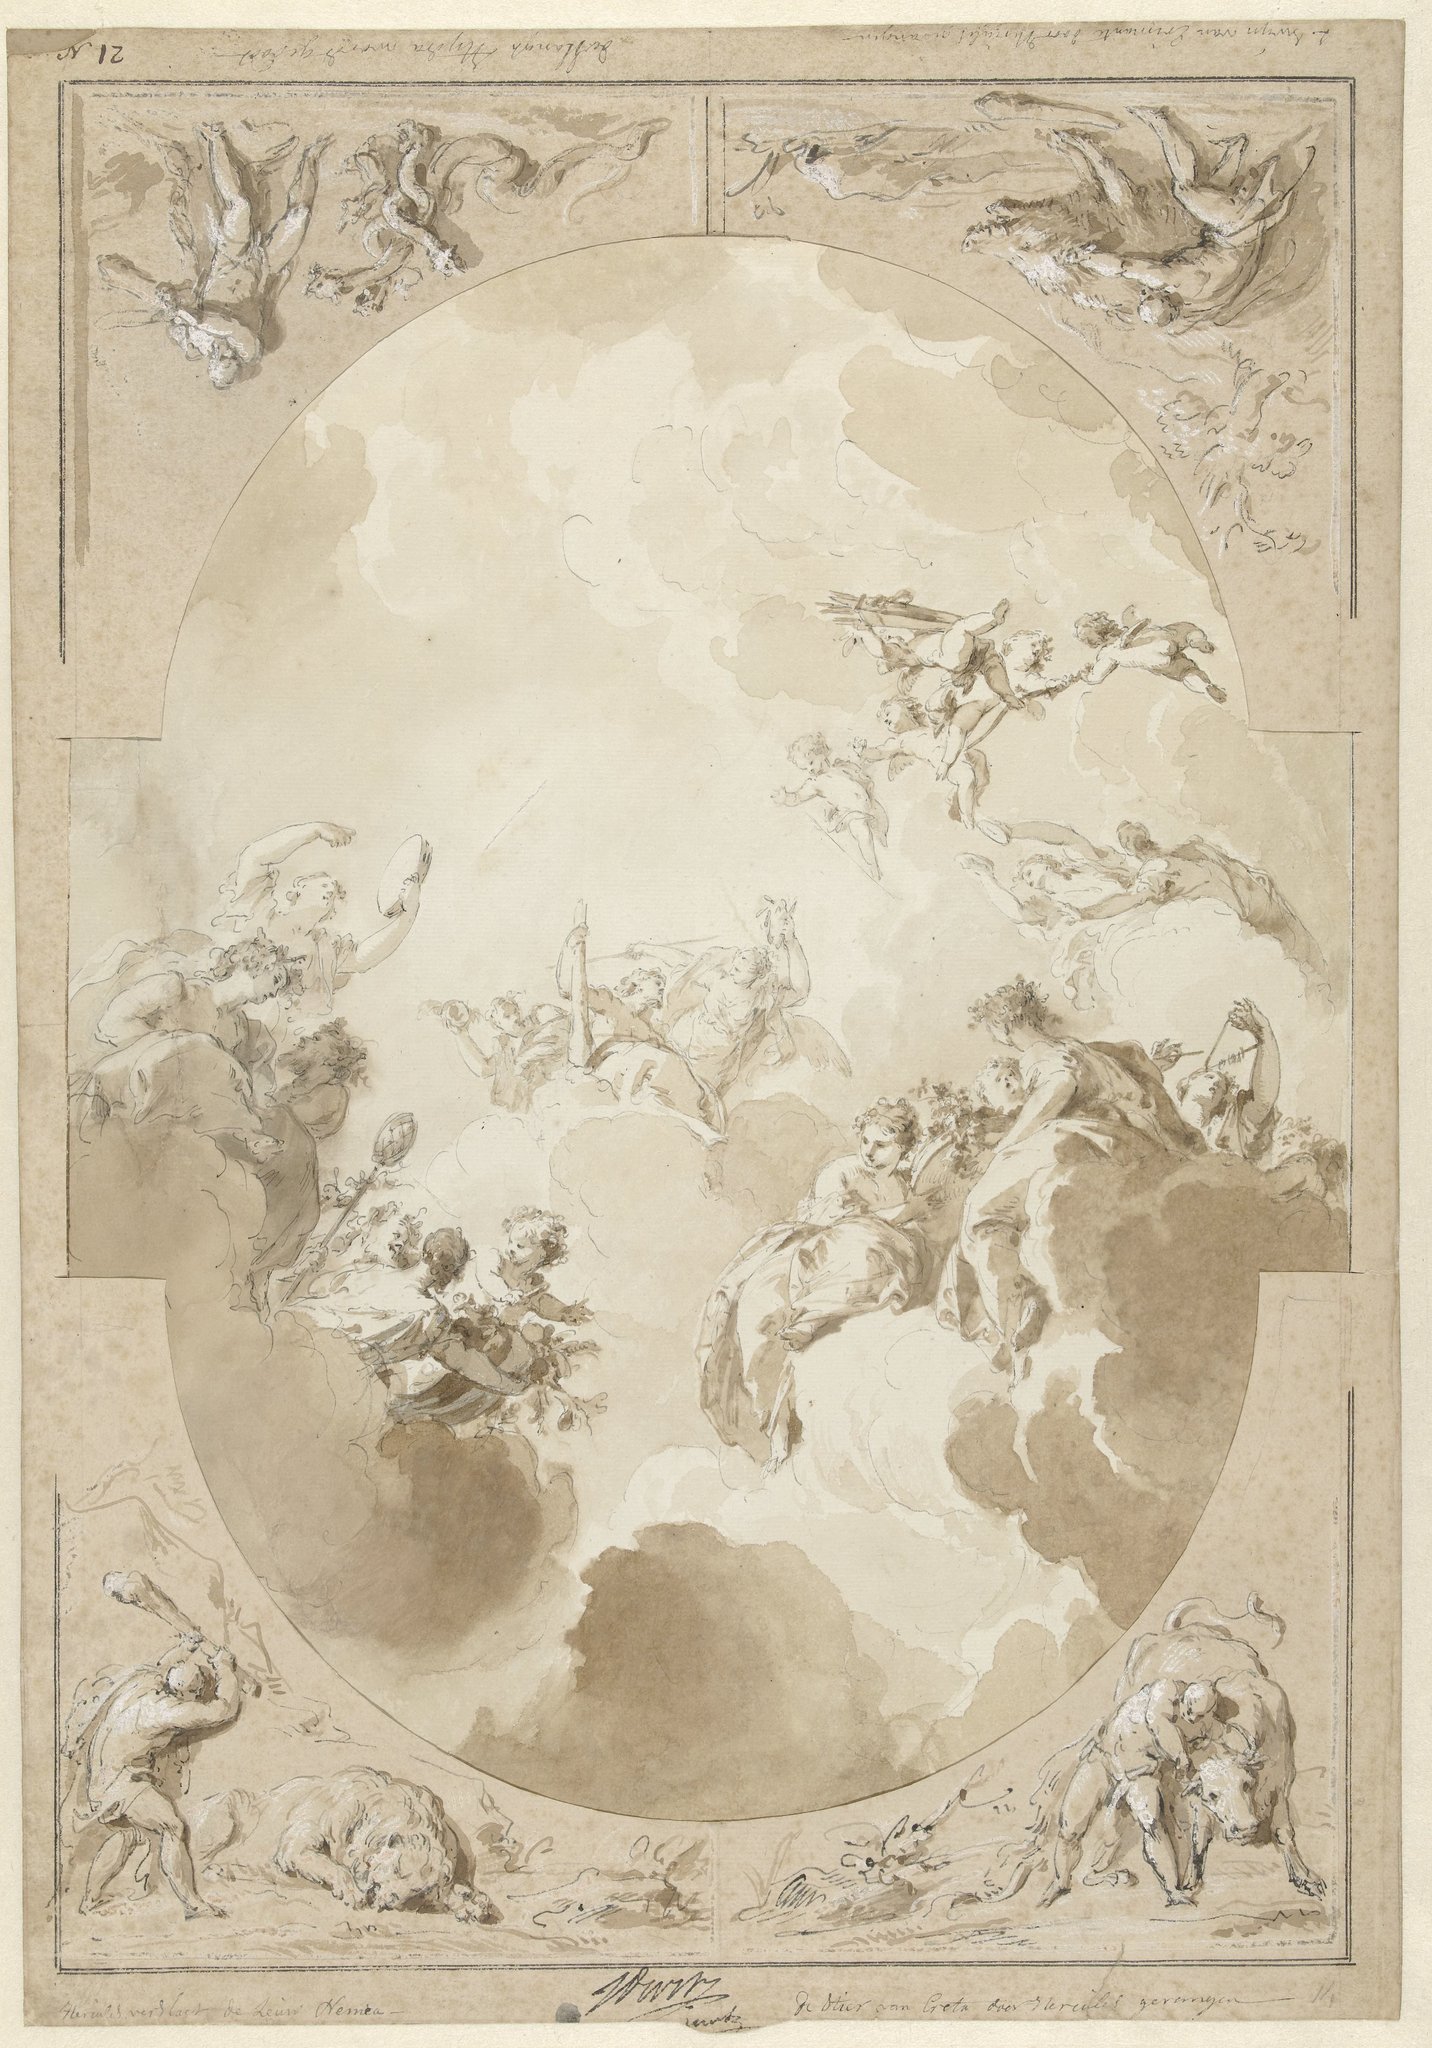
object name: drawing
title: Ontwerp voor een plafondschildering met de apotheose van Hercules en vier van zijn werken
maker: jacob de wit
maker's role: draughtsman, painter, print maker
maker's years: 1695-1754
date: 1746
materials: ink, paper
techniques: brush, pen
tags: (7) the cretan bull is captured by hercules, (2) the hydra of lerna is killed by hercules, (1) hercules chokes the nemean lion with his arms, (4) the erymanthian boar is captured by hercules, sitting or standing on clouds, apotheosis of hercules: he is borne to heaven in a four-horse chariot and reconciled with juno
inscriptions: inscription: ‘Hoekstuck voor mejuffrouw de wed.e AB Barnards 1746 te Haarlem’, inscription: ‘Blaffon geschildert voor Mejuffrouw de wed.e AB Barnard’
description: Ontwerp voor een plafondschildering met de apotheose van Hercules en vier van zijn werken. Opschrift bij zwikvullingen: 't Zwijn van Erimante door Hercules gevangen / De Slangh Hydra wordt gedoot / De stier van Creta door Hercules gevangen / Hercules verslaat de leuw Nemea.